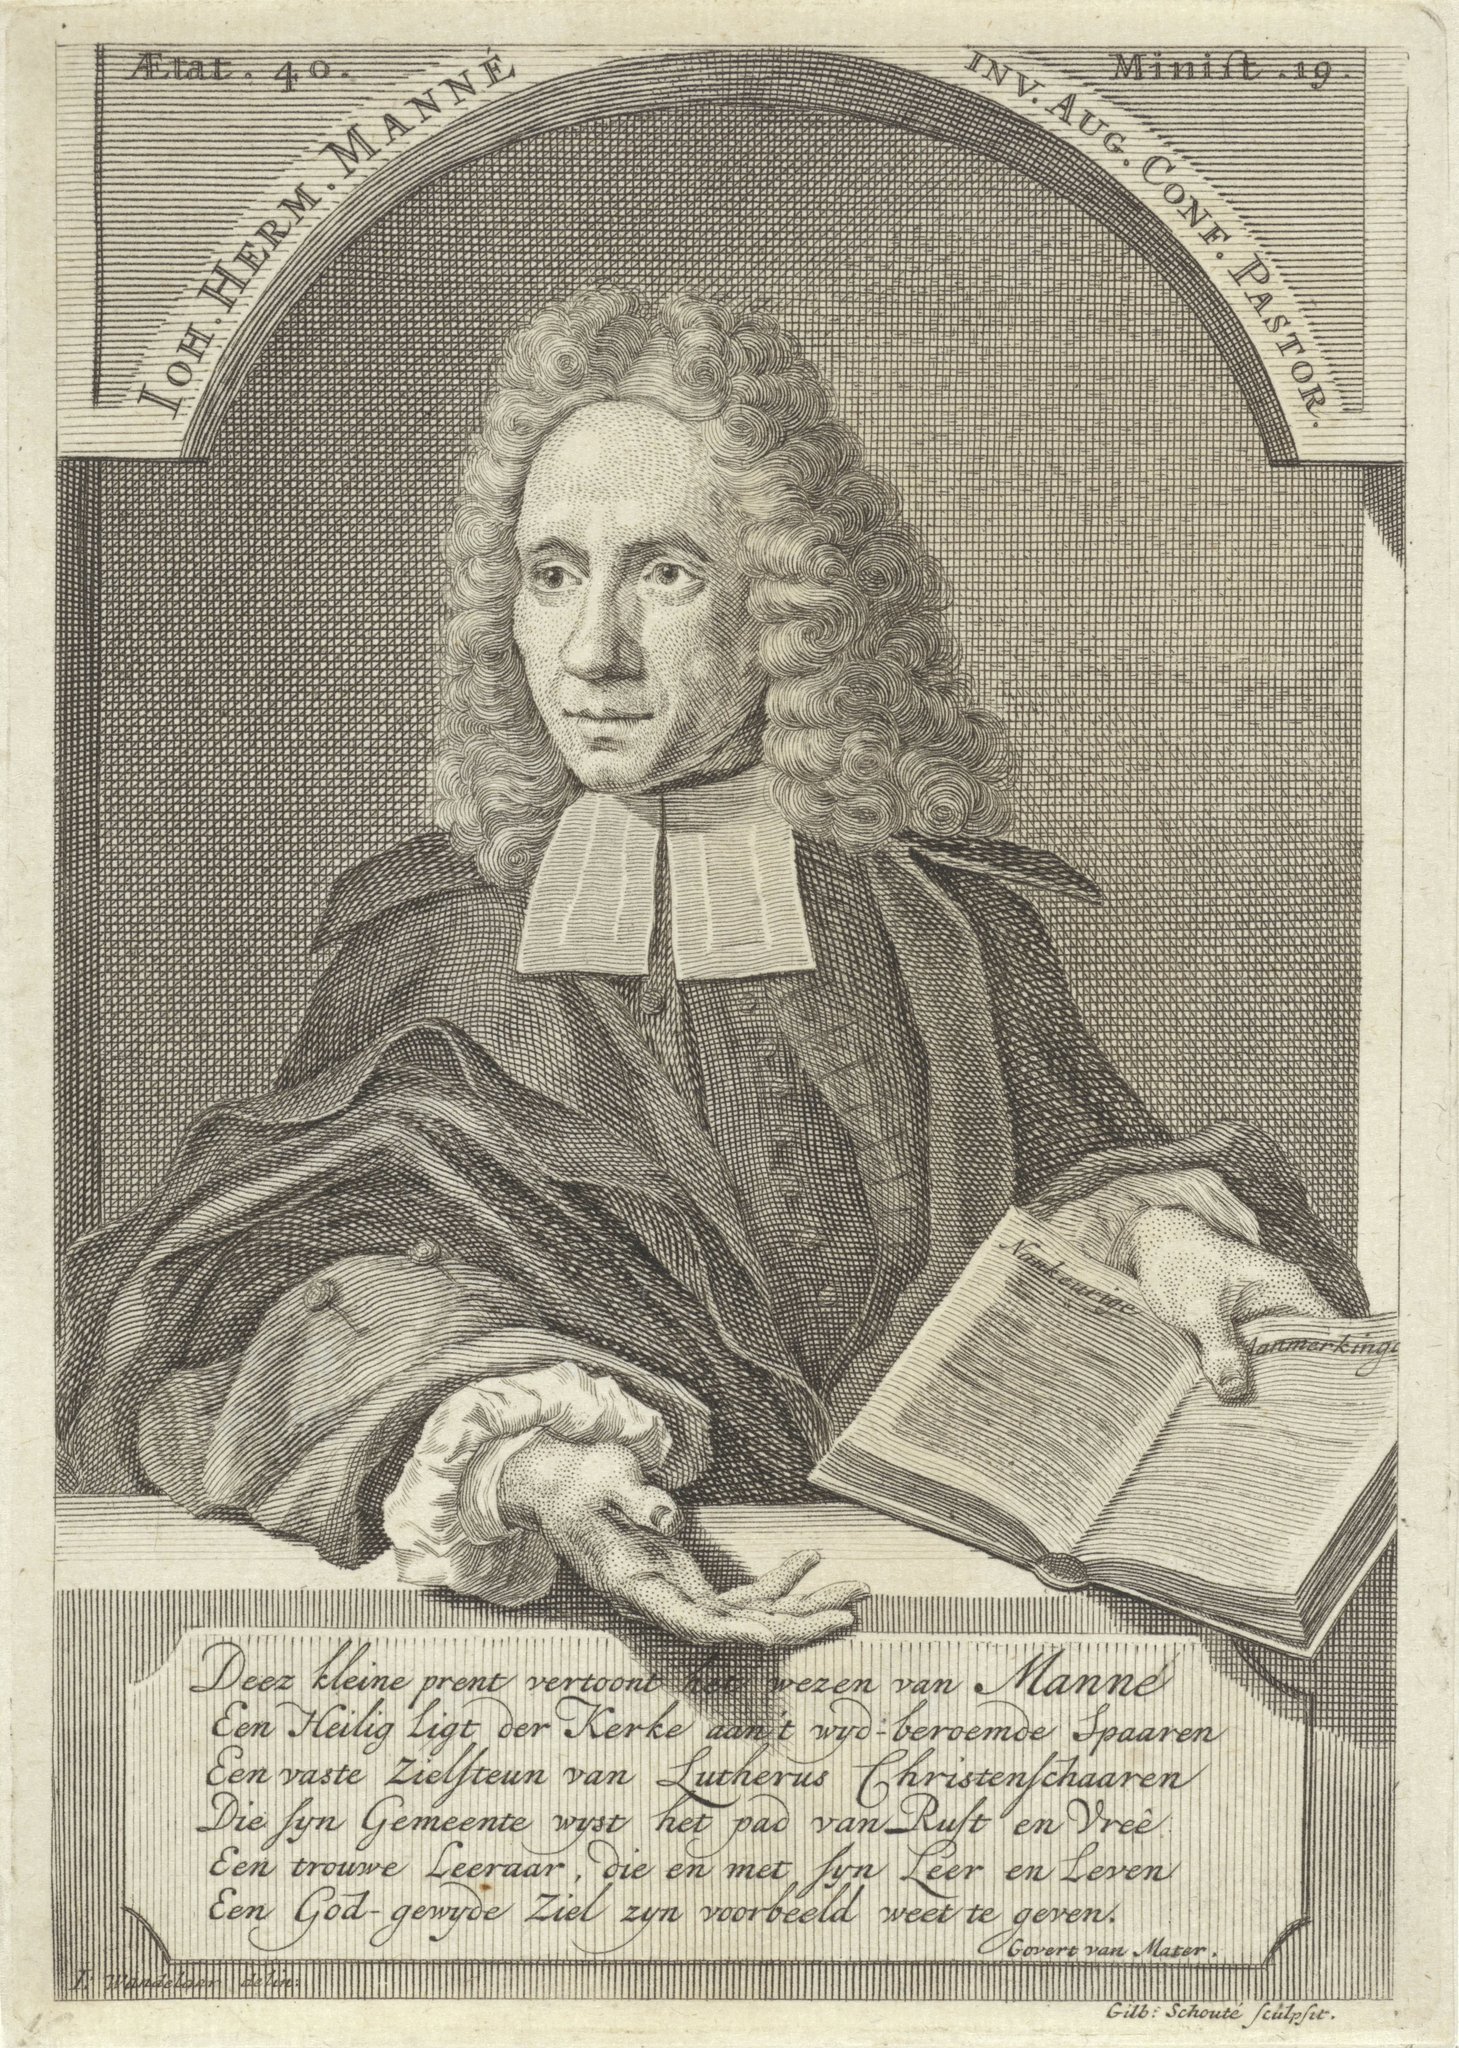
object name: print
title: Portret van de predikant Johannes Hermanus Manné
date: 1719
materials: paper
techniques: etching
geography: amsterdam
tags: schrijver, johannes hermannus manné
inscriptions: collector's mark: Lugt 2166, collector's mark: Lugt 2760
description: Portret van de lutherse predikant Johannes Hermanus Manné in een stenen nis met open boek in zijn hand. Onder het portret een Nederlands vers op de geportretteerde door Govert van Maser.